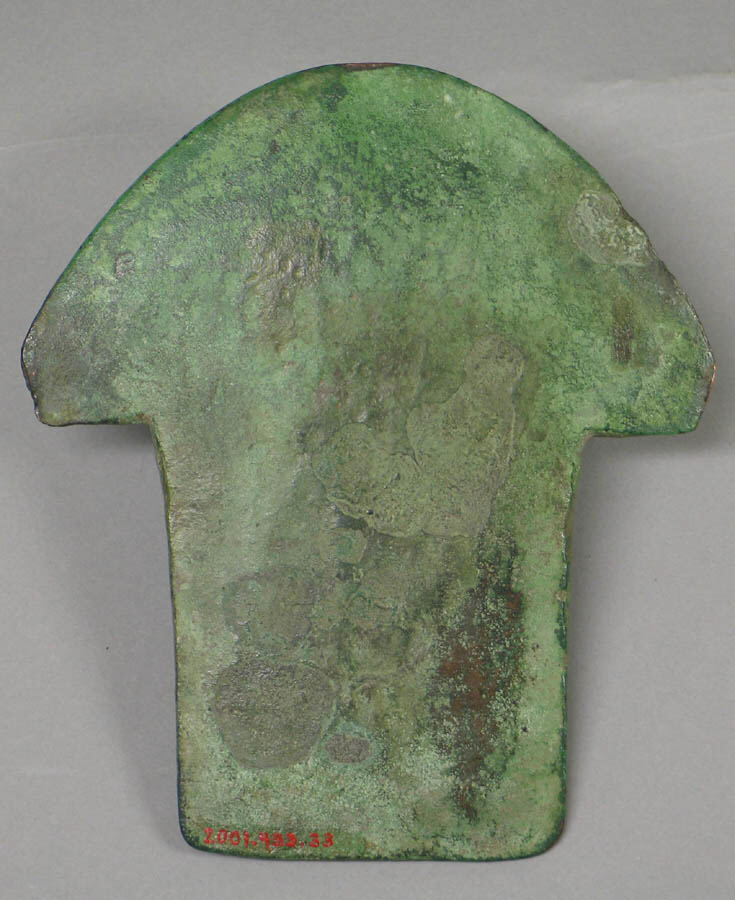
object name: ax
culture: indian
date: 1500-500 BCE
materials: copper